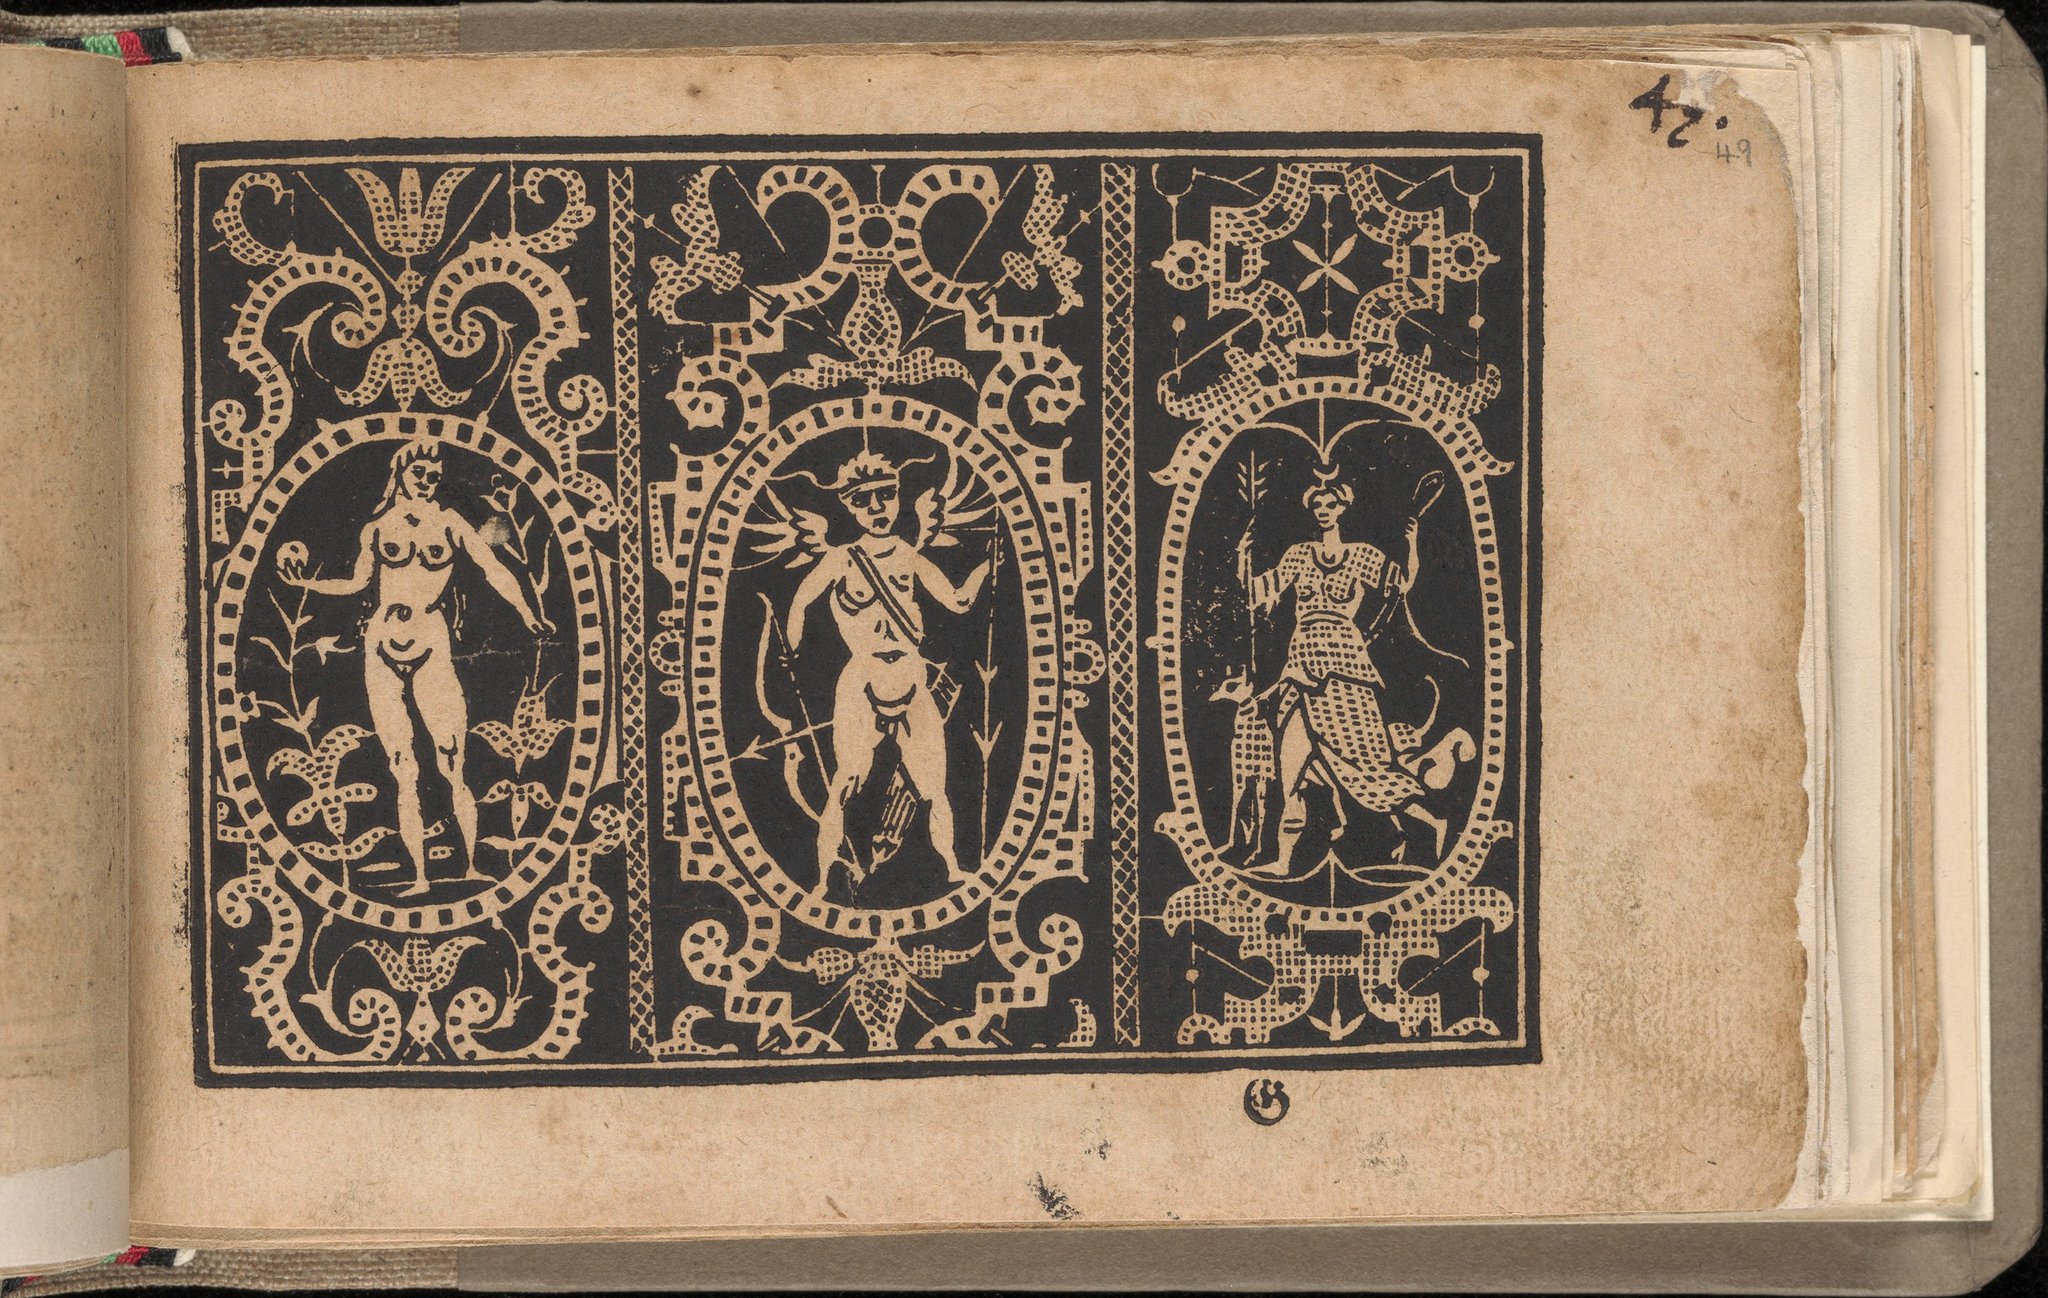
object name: book print ornament architecture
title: Schön newes Modelbuch (Page 49r)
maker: sigismundus latomus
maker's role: publisher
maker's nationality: german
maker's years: 1599-1632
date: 1608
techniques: woodcut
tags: female nudes